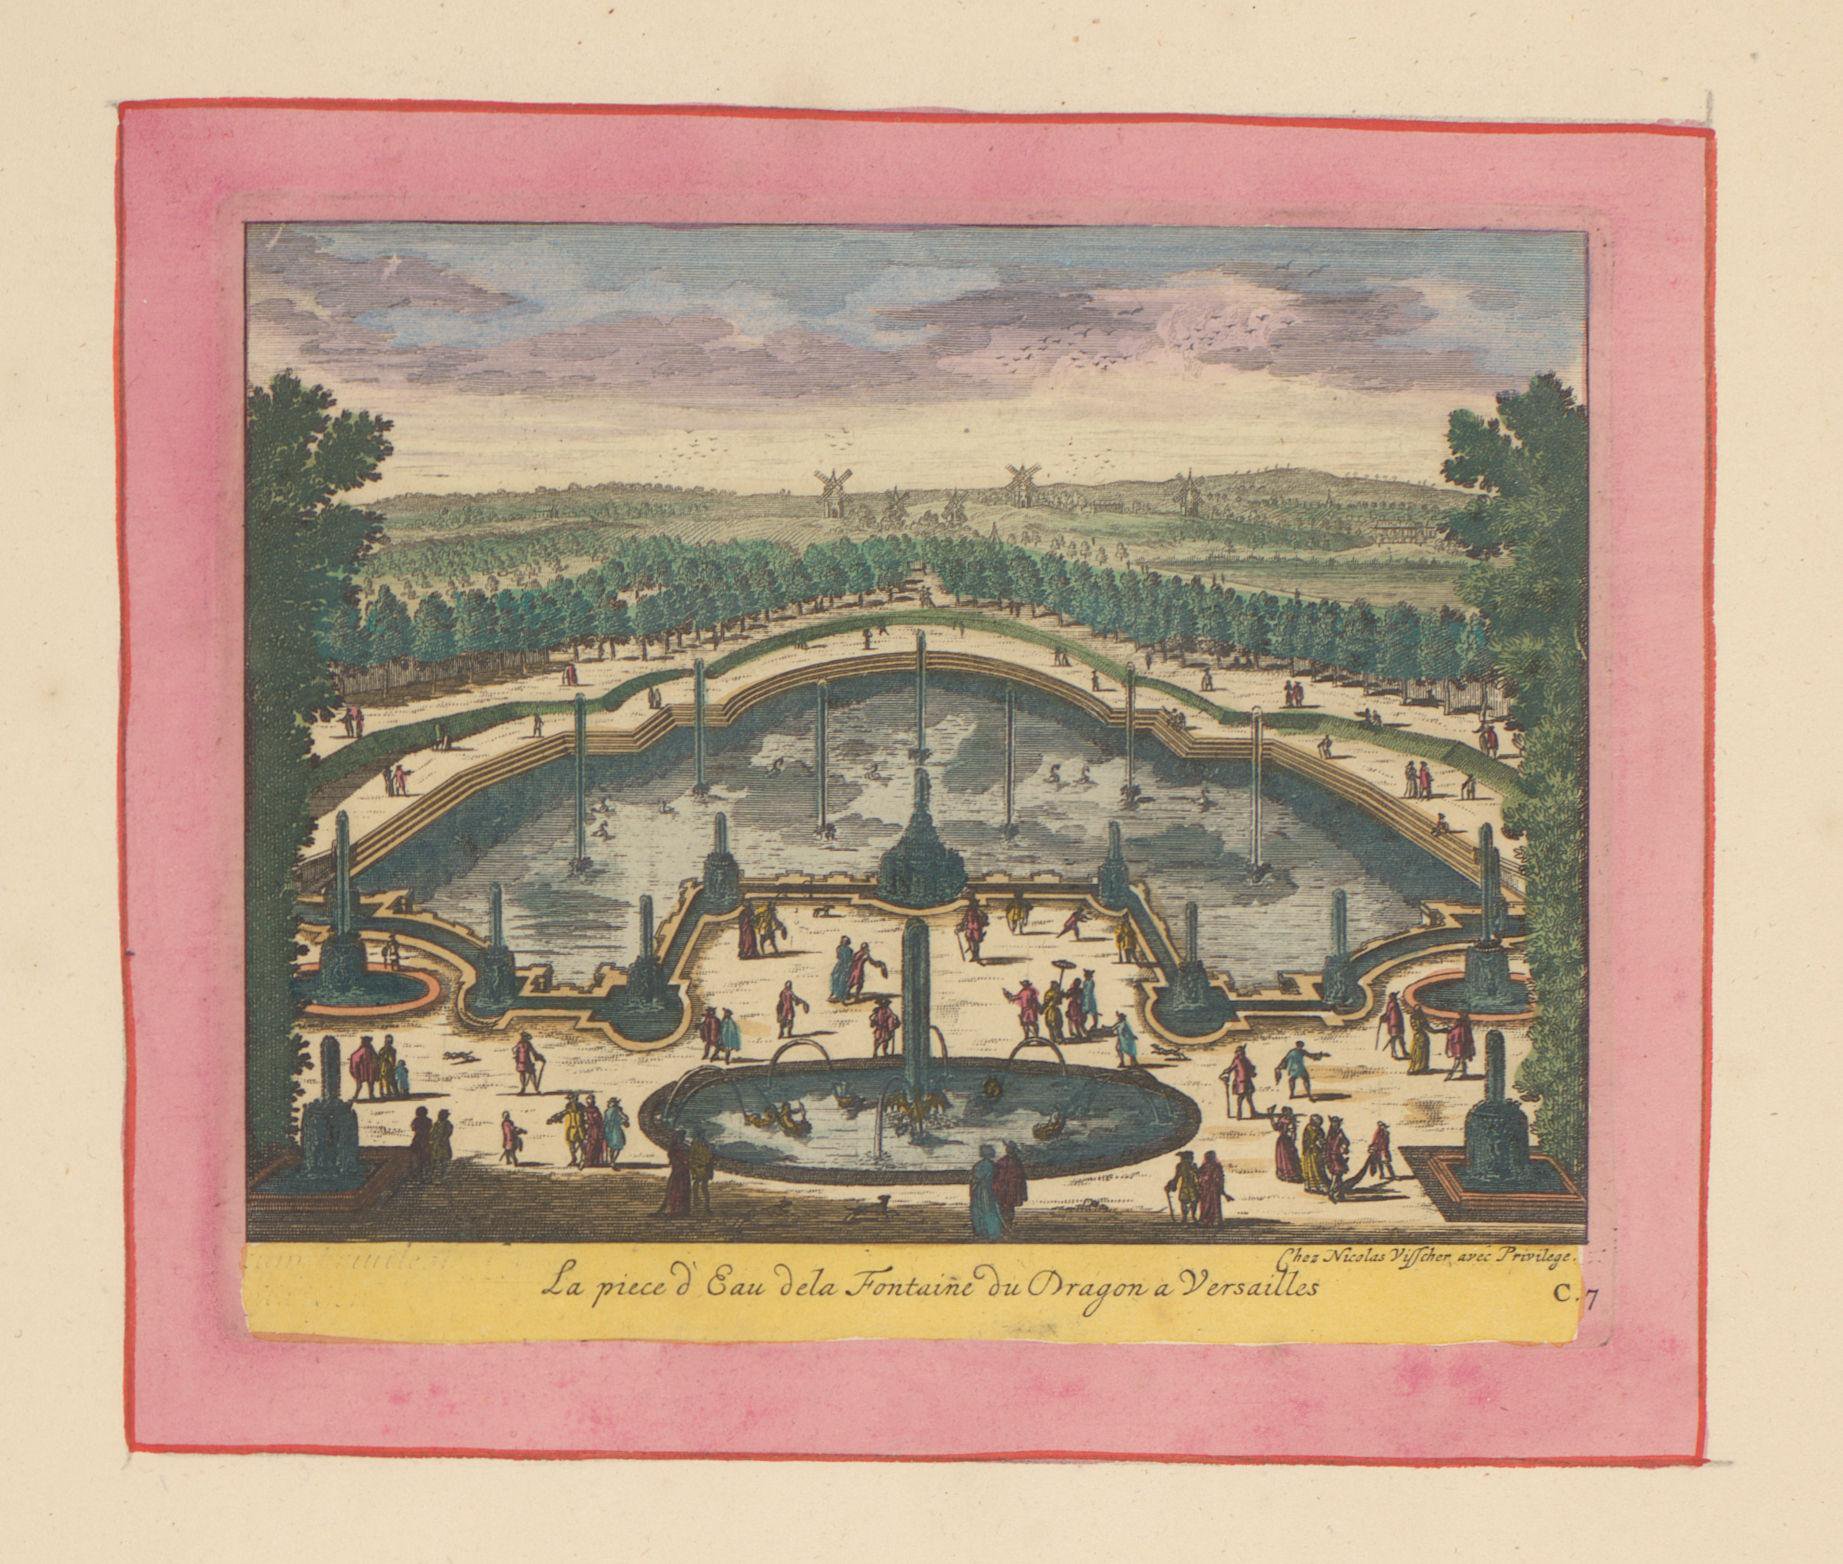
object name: print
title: La piece d'Eau dela Fontaine du Dragon a Versailles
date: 1686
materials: paper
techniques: etching, hand coloring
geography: amsterdam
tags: garden fountain, french or architectonic garden; formal garden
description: De prent maakt deel uit van een serie bestaande uit 87 genummerde prenten (volgens Hollstein). De serie is opgedeeld in de delen A t/m F.